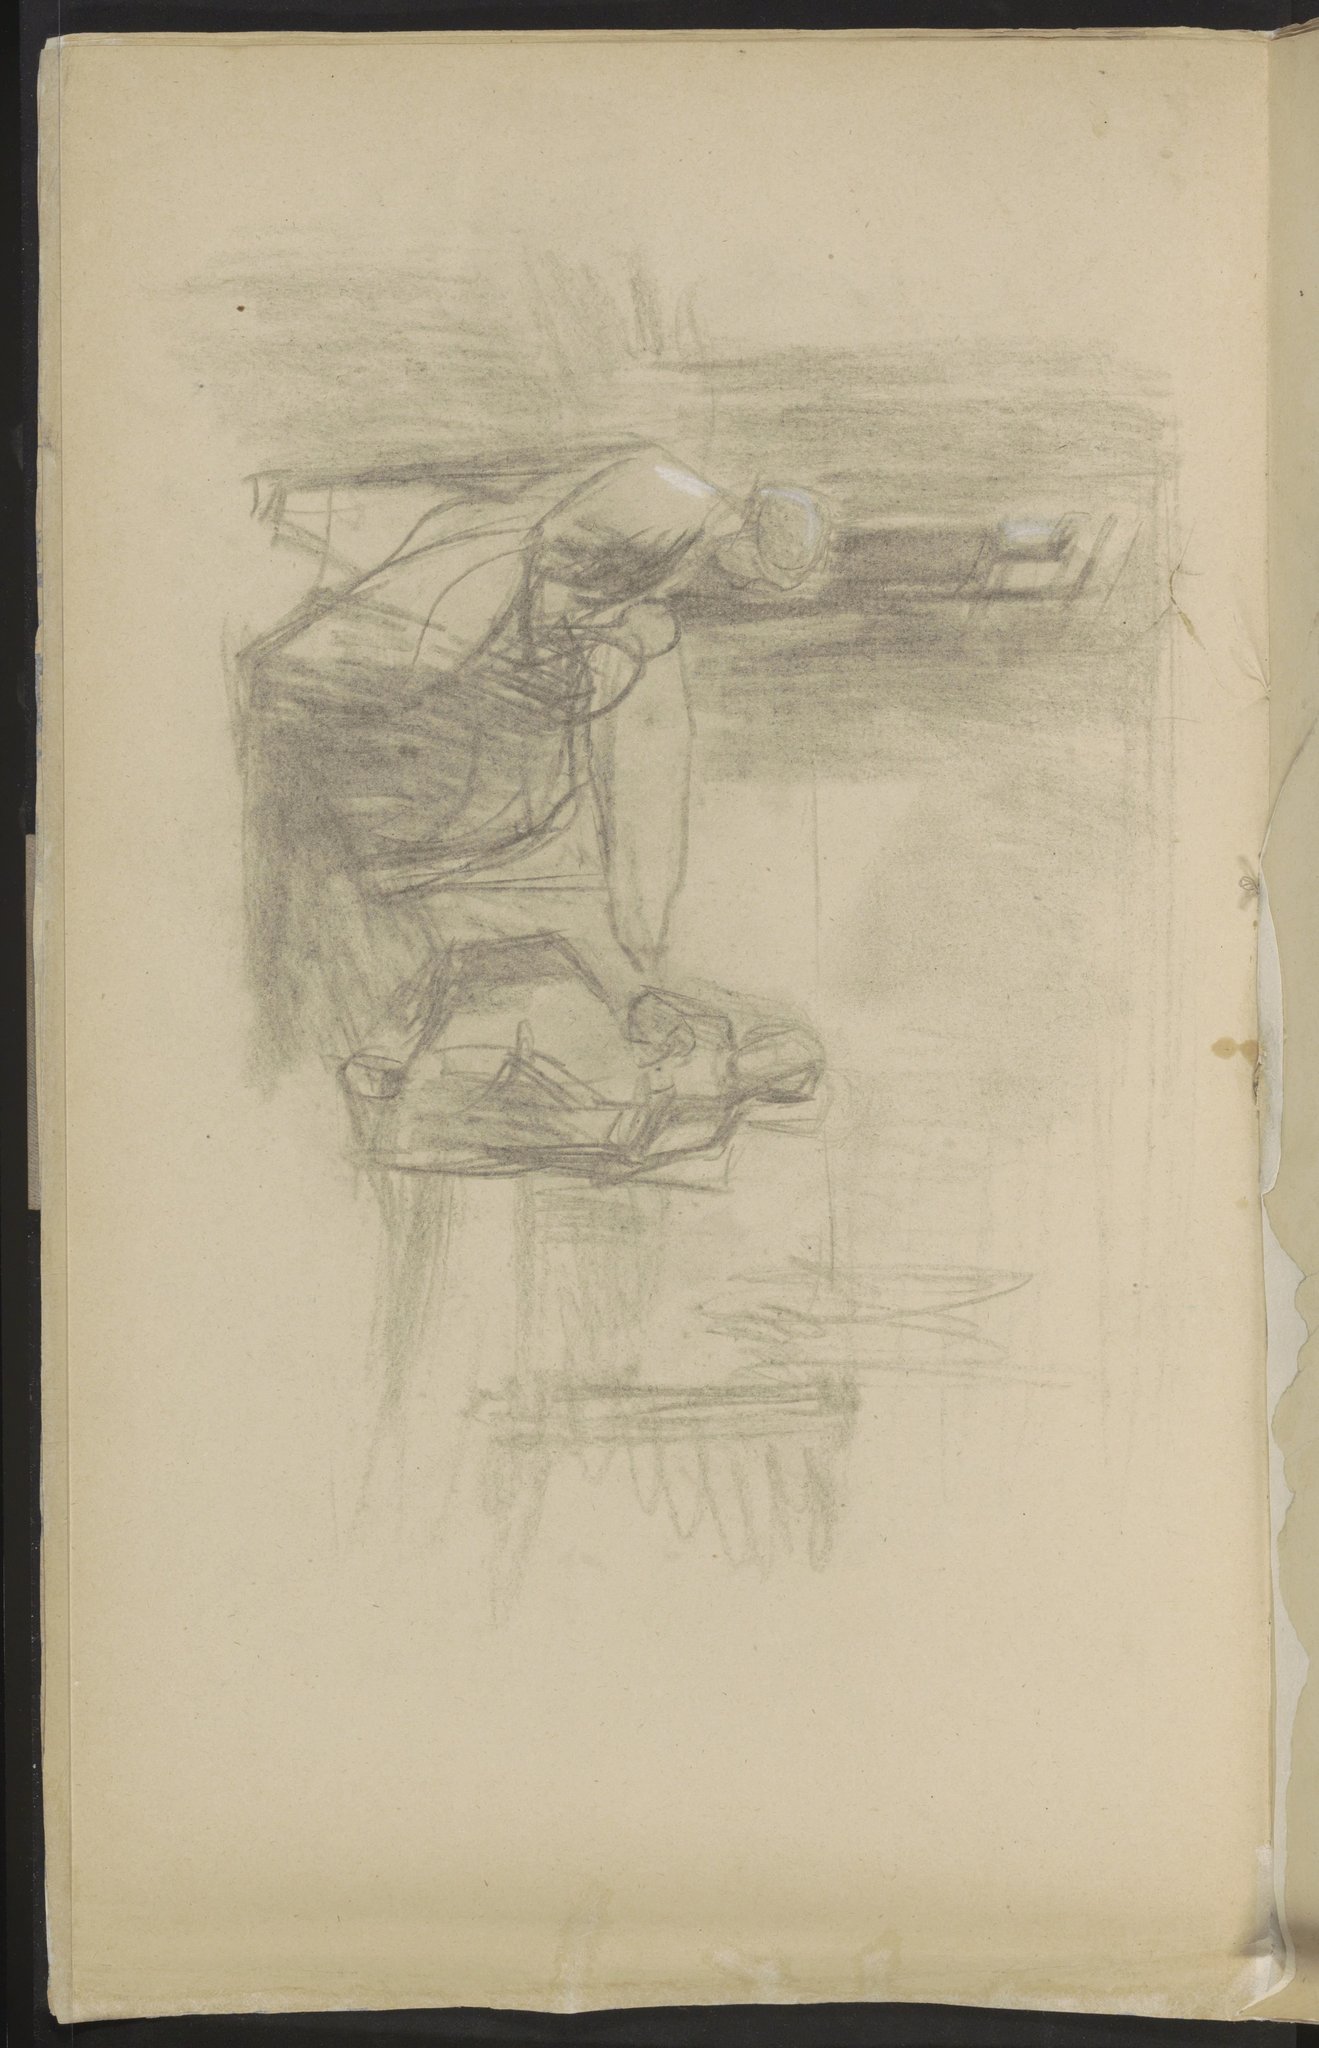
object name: sketchbook leaf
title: Interieur met twee handwerkende vrouwen bij een tafel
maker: albert neuhuys (1844-1914)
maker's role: draughtsman, painter, print maker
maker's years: 1844-1914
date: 1854-1914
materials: charcoal, paint, paper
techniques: brush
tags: sitting figure, adult woman, table, interior of the house, home sewing; repair of clothes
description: Blad 5 recto uit een schetsboek met 53 bladen.